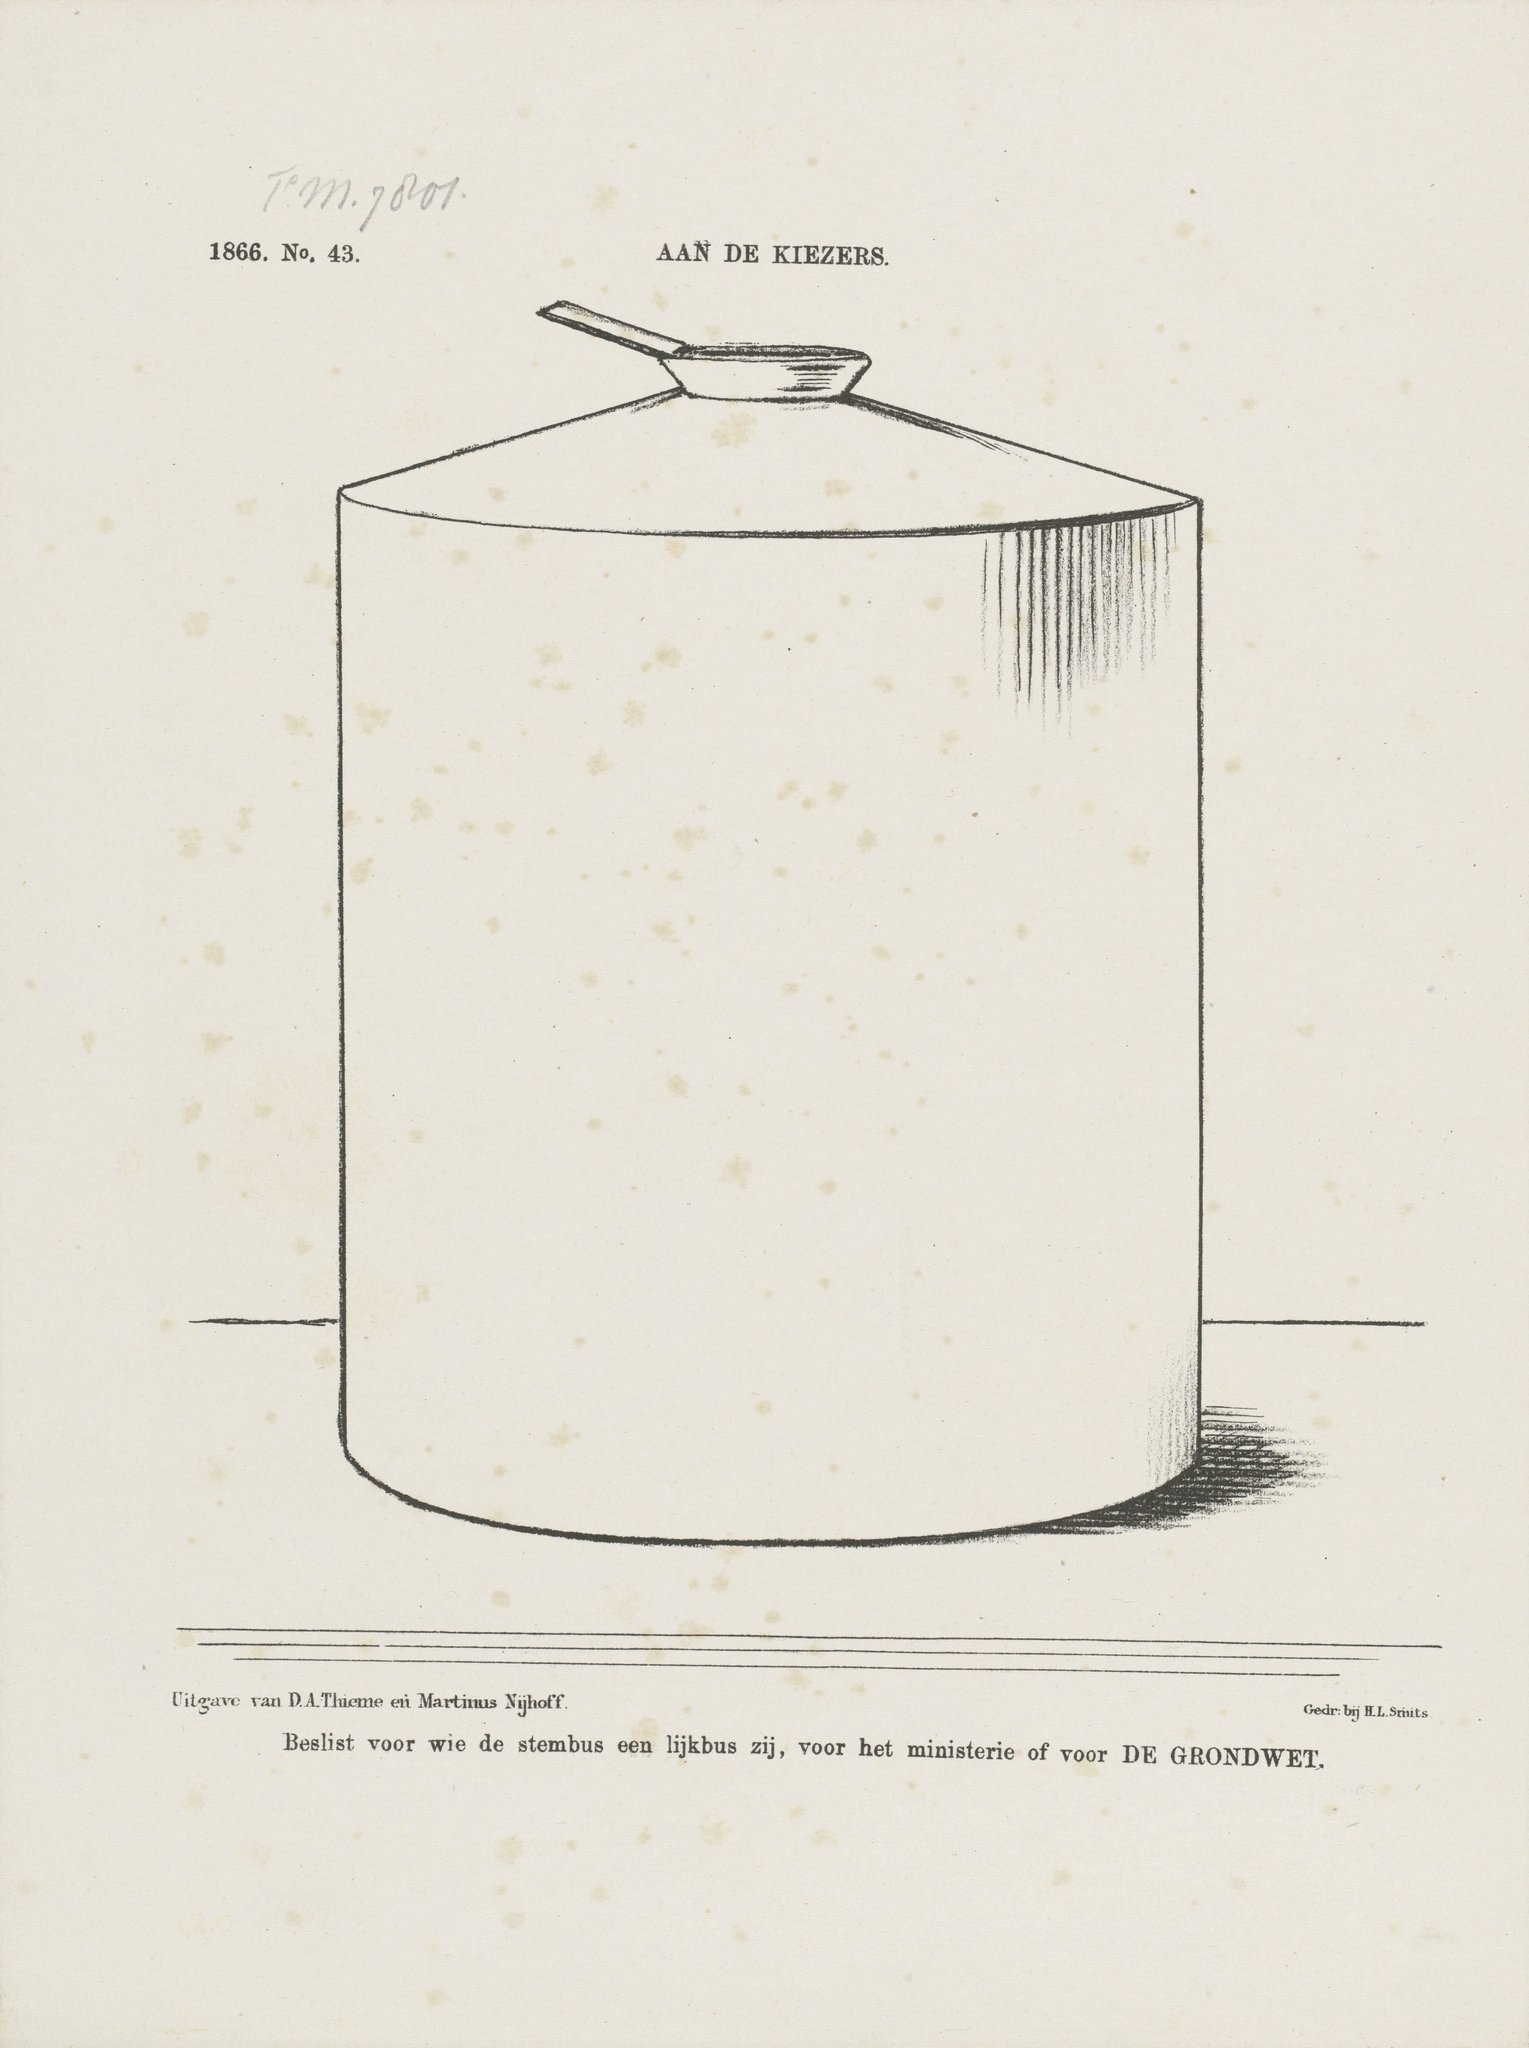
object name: print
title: Spotprent met een stembus, 1866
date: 1866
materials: paper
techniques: lithograph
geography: the hague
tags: voting receptacle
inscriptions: collector's mark: Lugt 2228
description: Spotprent met een stembus, naar aanleiding van de nieuwe verkiezingen na de ontbinding van de beide Kamers. Plaat verschenen bij het weekblad De Nederlandsche Spectator, nr. 43, 27 oktober 1866.